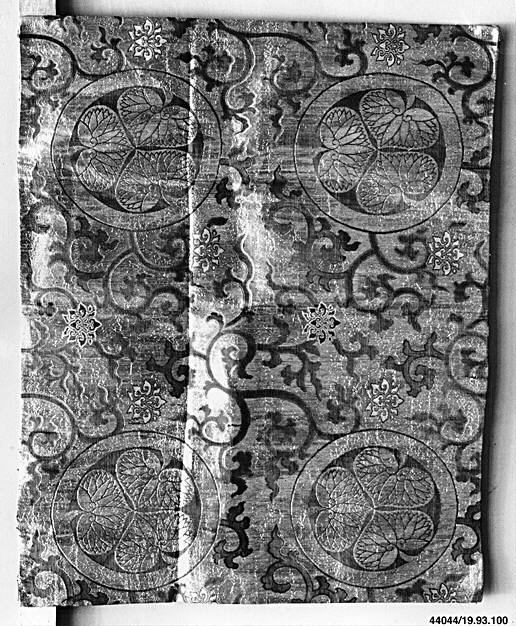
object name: altar cloth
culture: japanese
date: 1716-1736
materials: metal thread, silk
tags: flowers